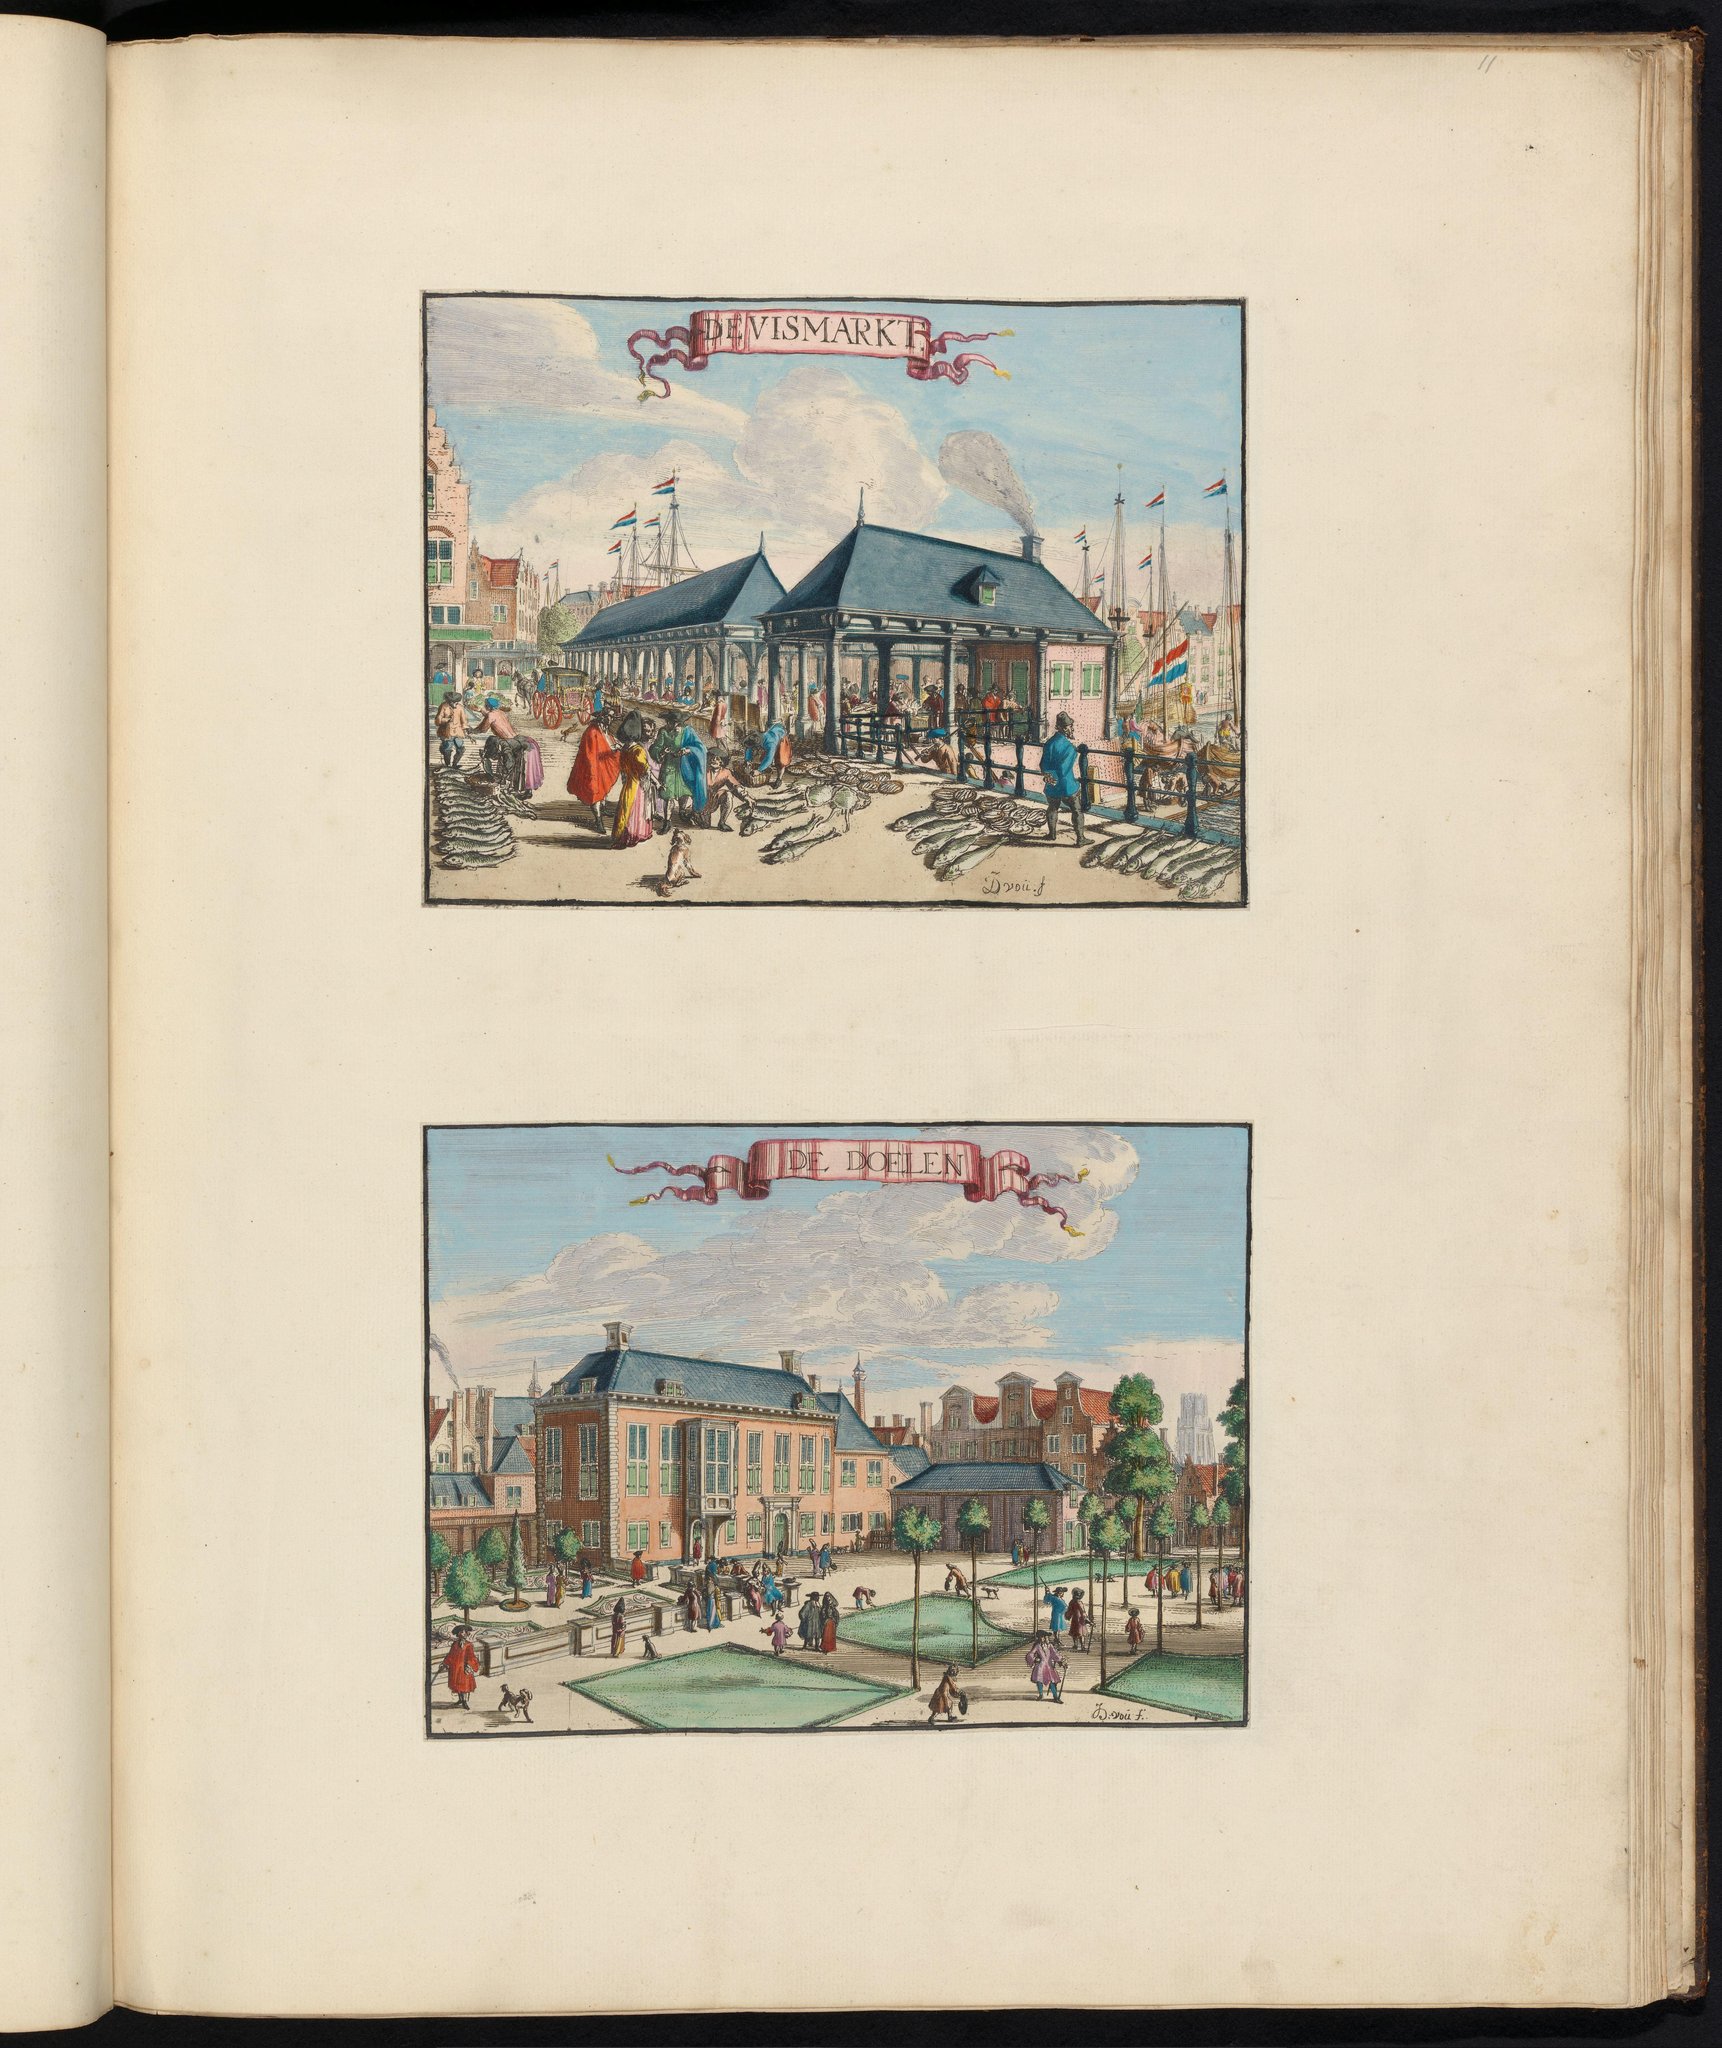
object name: album leaf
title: De Vismarkt / De Doelen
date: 1694-1695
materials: paper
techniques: colour, etching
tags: rotterdam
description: Twee voorstellingen op een albumblad. Boven de Zeevismarkt aan de Blaak bij de Leuvehaven te Rotterdam, gezien vanuit het westen. Onder een gezicht op de achterzijde en binnenplaats van de Sint-Jorisdoelen aan het Haagseveer te Rotterdam. Rechtsboven de letters G en H. De prenten zijn onderdeel van de kaart van Rotterdam door Johannes de Vouw en maken deel uit van een album.